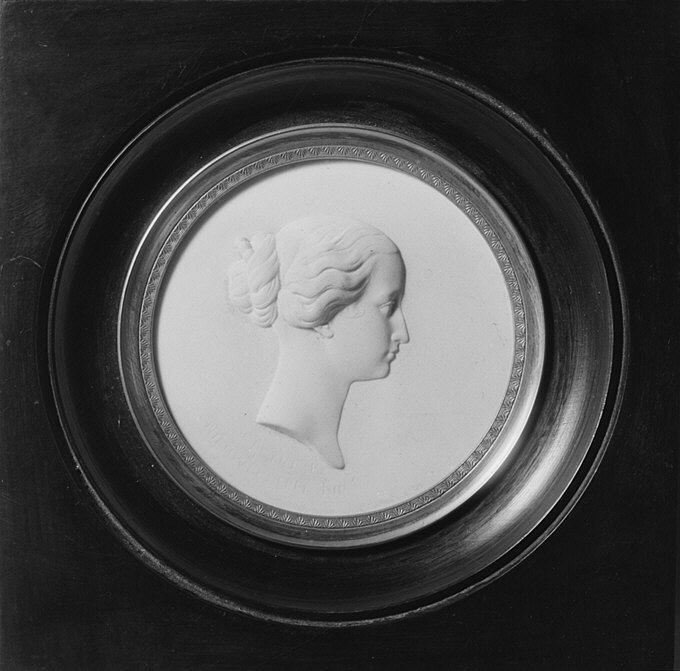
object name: medallion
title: Eugénie Marie de Montijo de Guzman (1826–1920), Empress of the French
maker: sèvres manufactory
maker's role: manufactory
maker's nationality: french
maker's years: 1740-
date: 1867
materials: biscuit, porcelain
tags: profiles,women